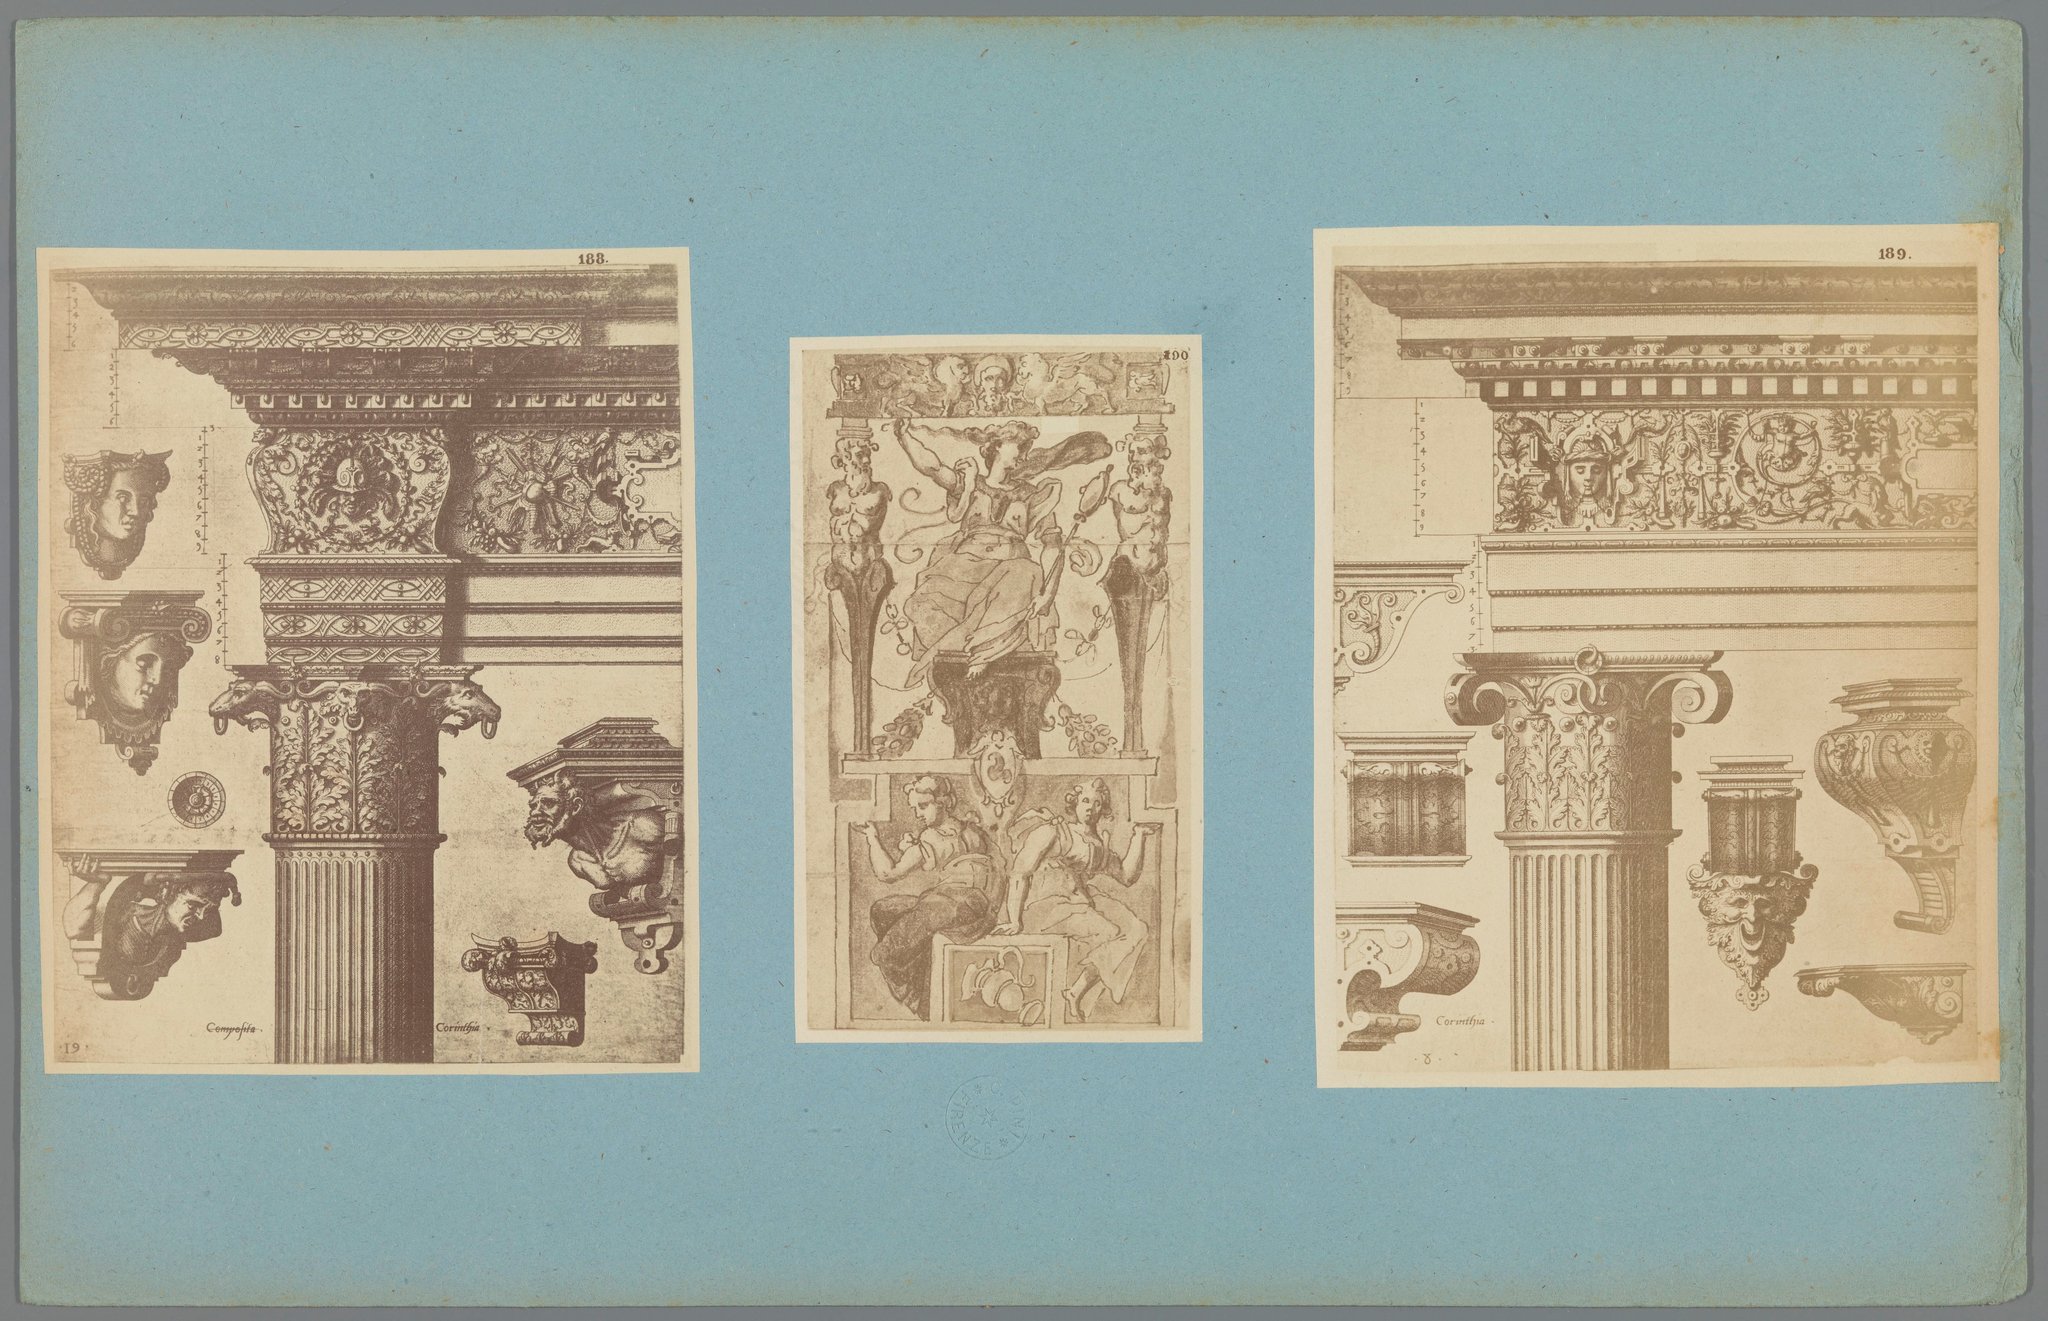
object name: photograph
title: Drie fotoreproducties van prenten en een tekening van architecturale elementen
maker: Anonymous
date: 1875-1900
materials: cardboard, photographic support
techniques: albumen print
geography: europe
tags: composite order ~ architecture, atlantes ~ architecture, corinthian order ~ architecture, europe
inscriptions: name: ‘C. PINI FIRENZE’, collector's mark: Lugt 3937, number: ‘38’, number: ‘190’, number: ‘189.’, number: ‘188.’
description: Links (188) een prent van elementen van de Korinthische en composiete zuilenorde, midden (190) een tekening van een vrouwfiguur met een scepter tussen twee atlanten, rechts (189) een prent van elementen van de Korinthische zuilenorde.